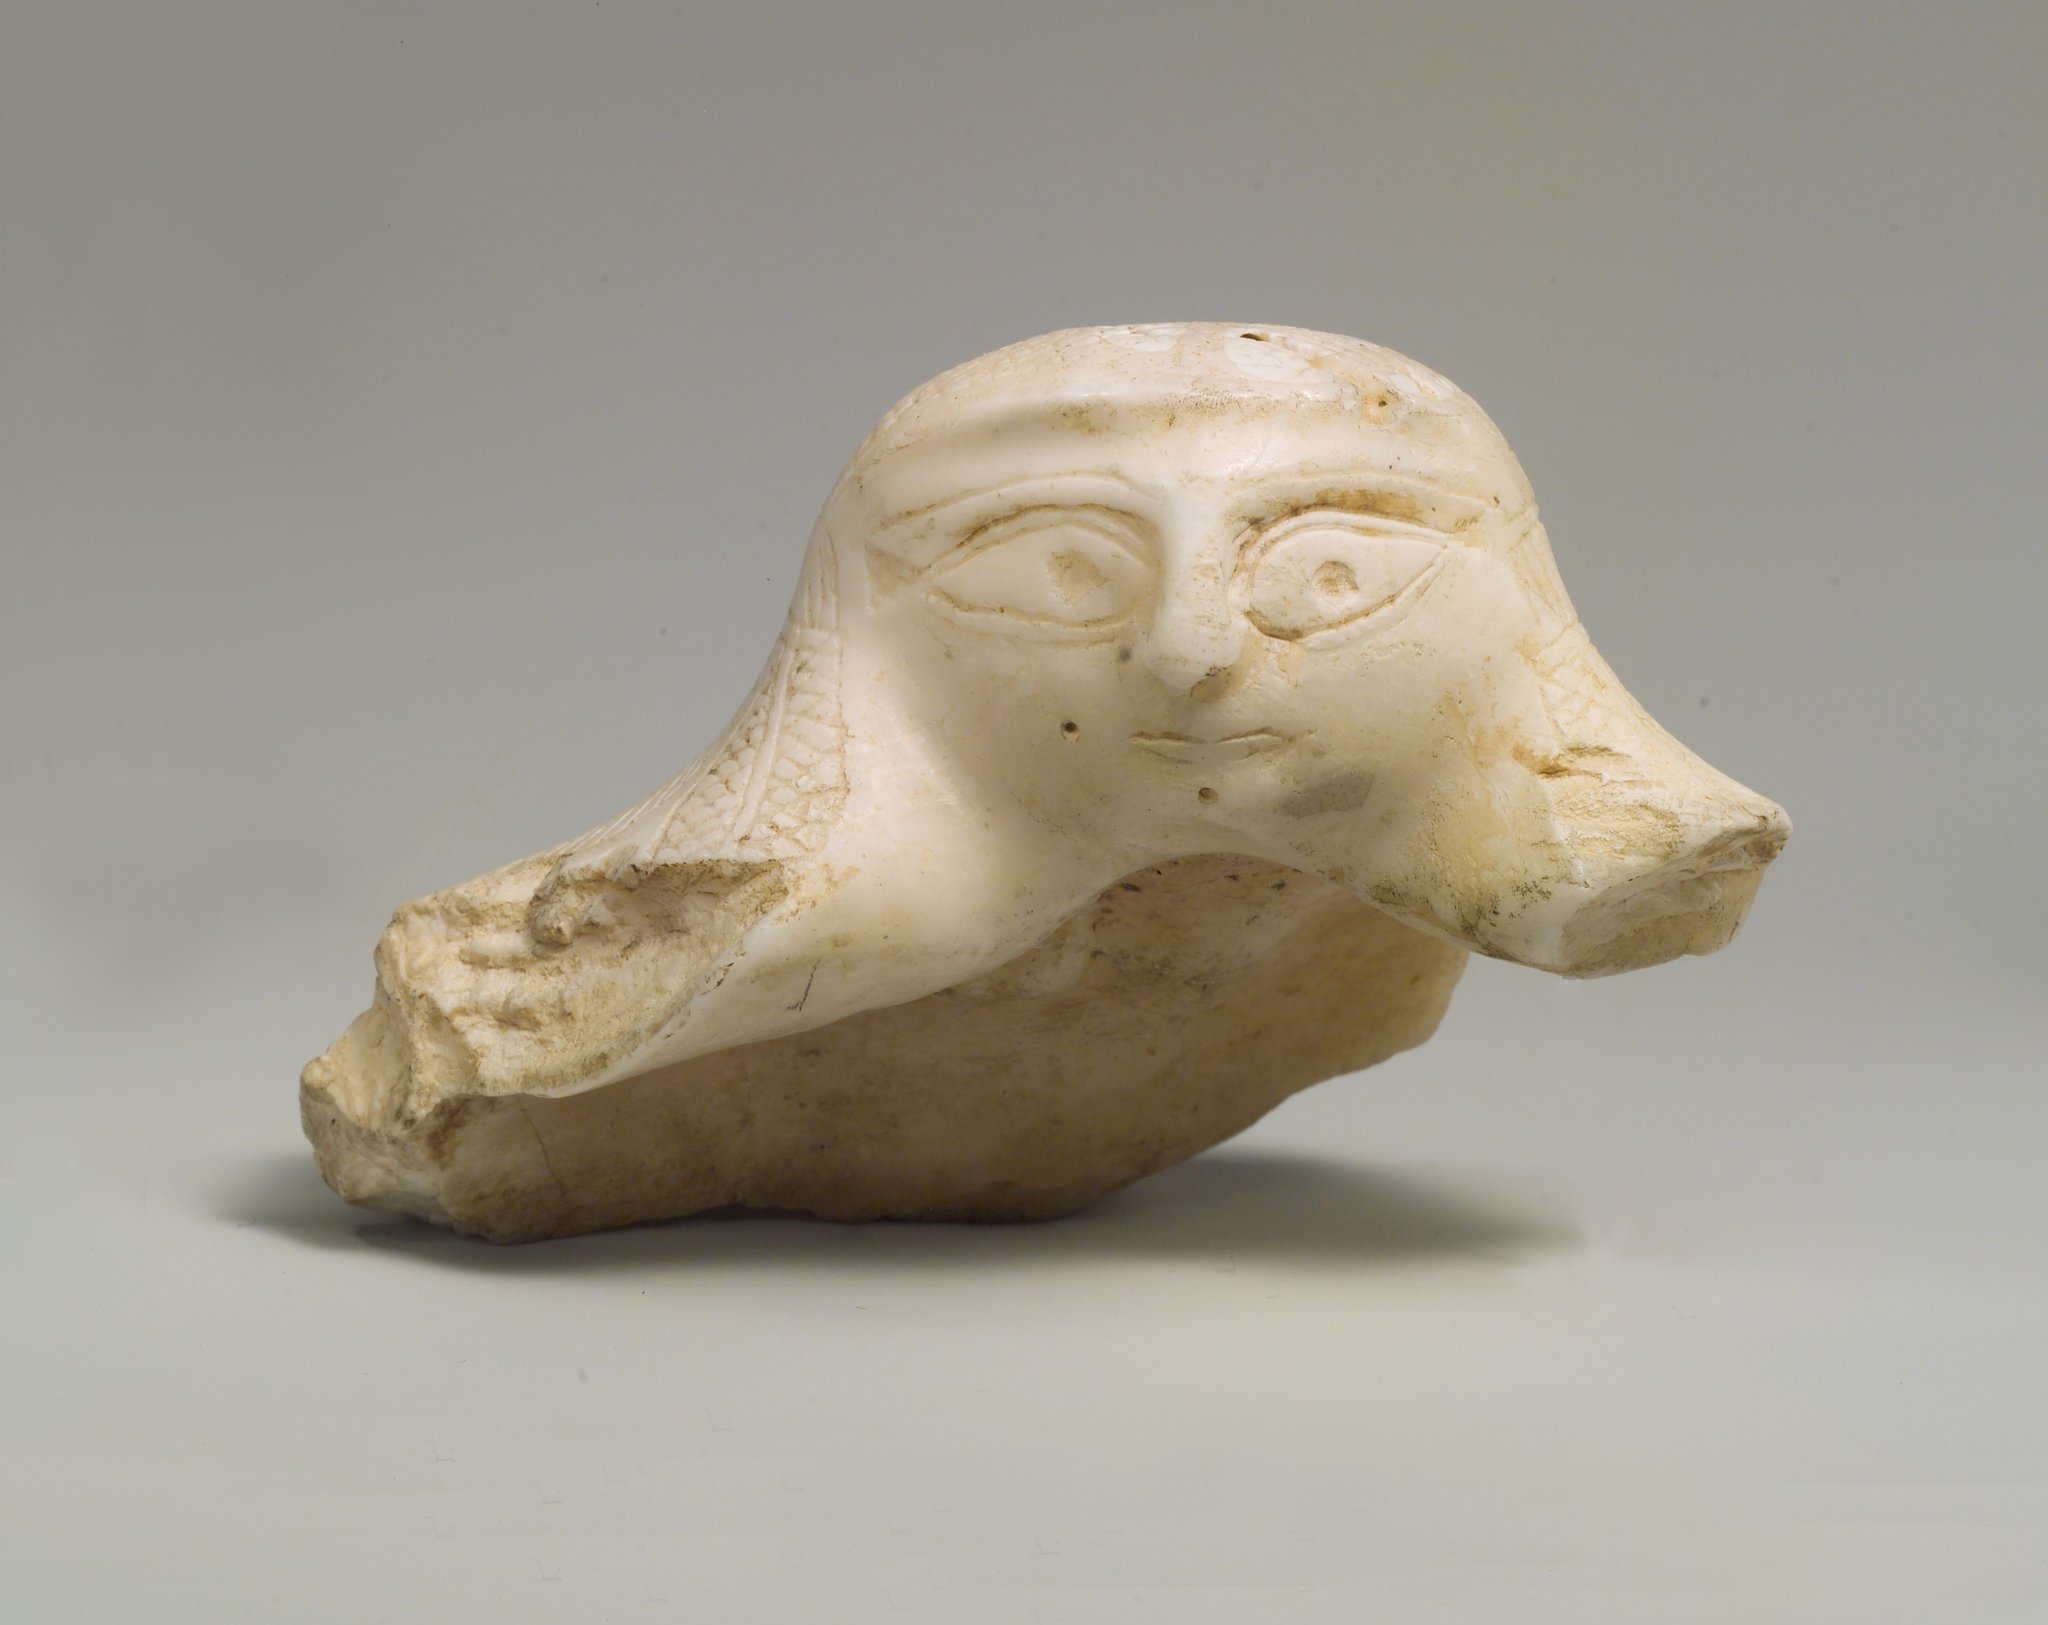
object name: sculpture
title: Fragment of a shell with a sculpted female head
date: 700-601 BCE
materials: shell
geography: levant or mesopotamia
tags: heads